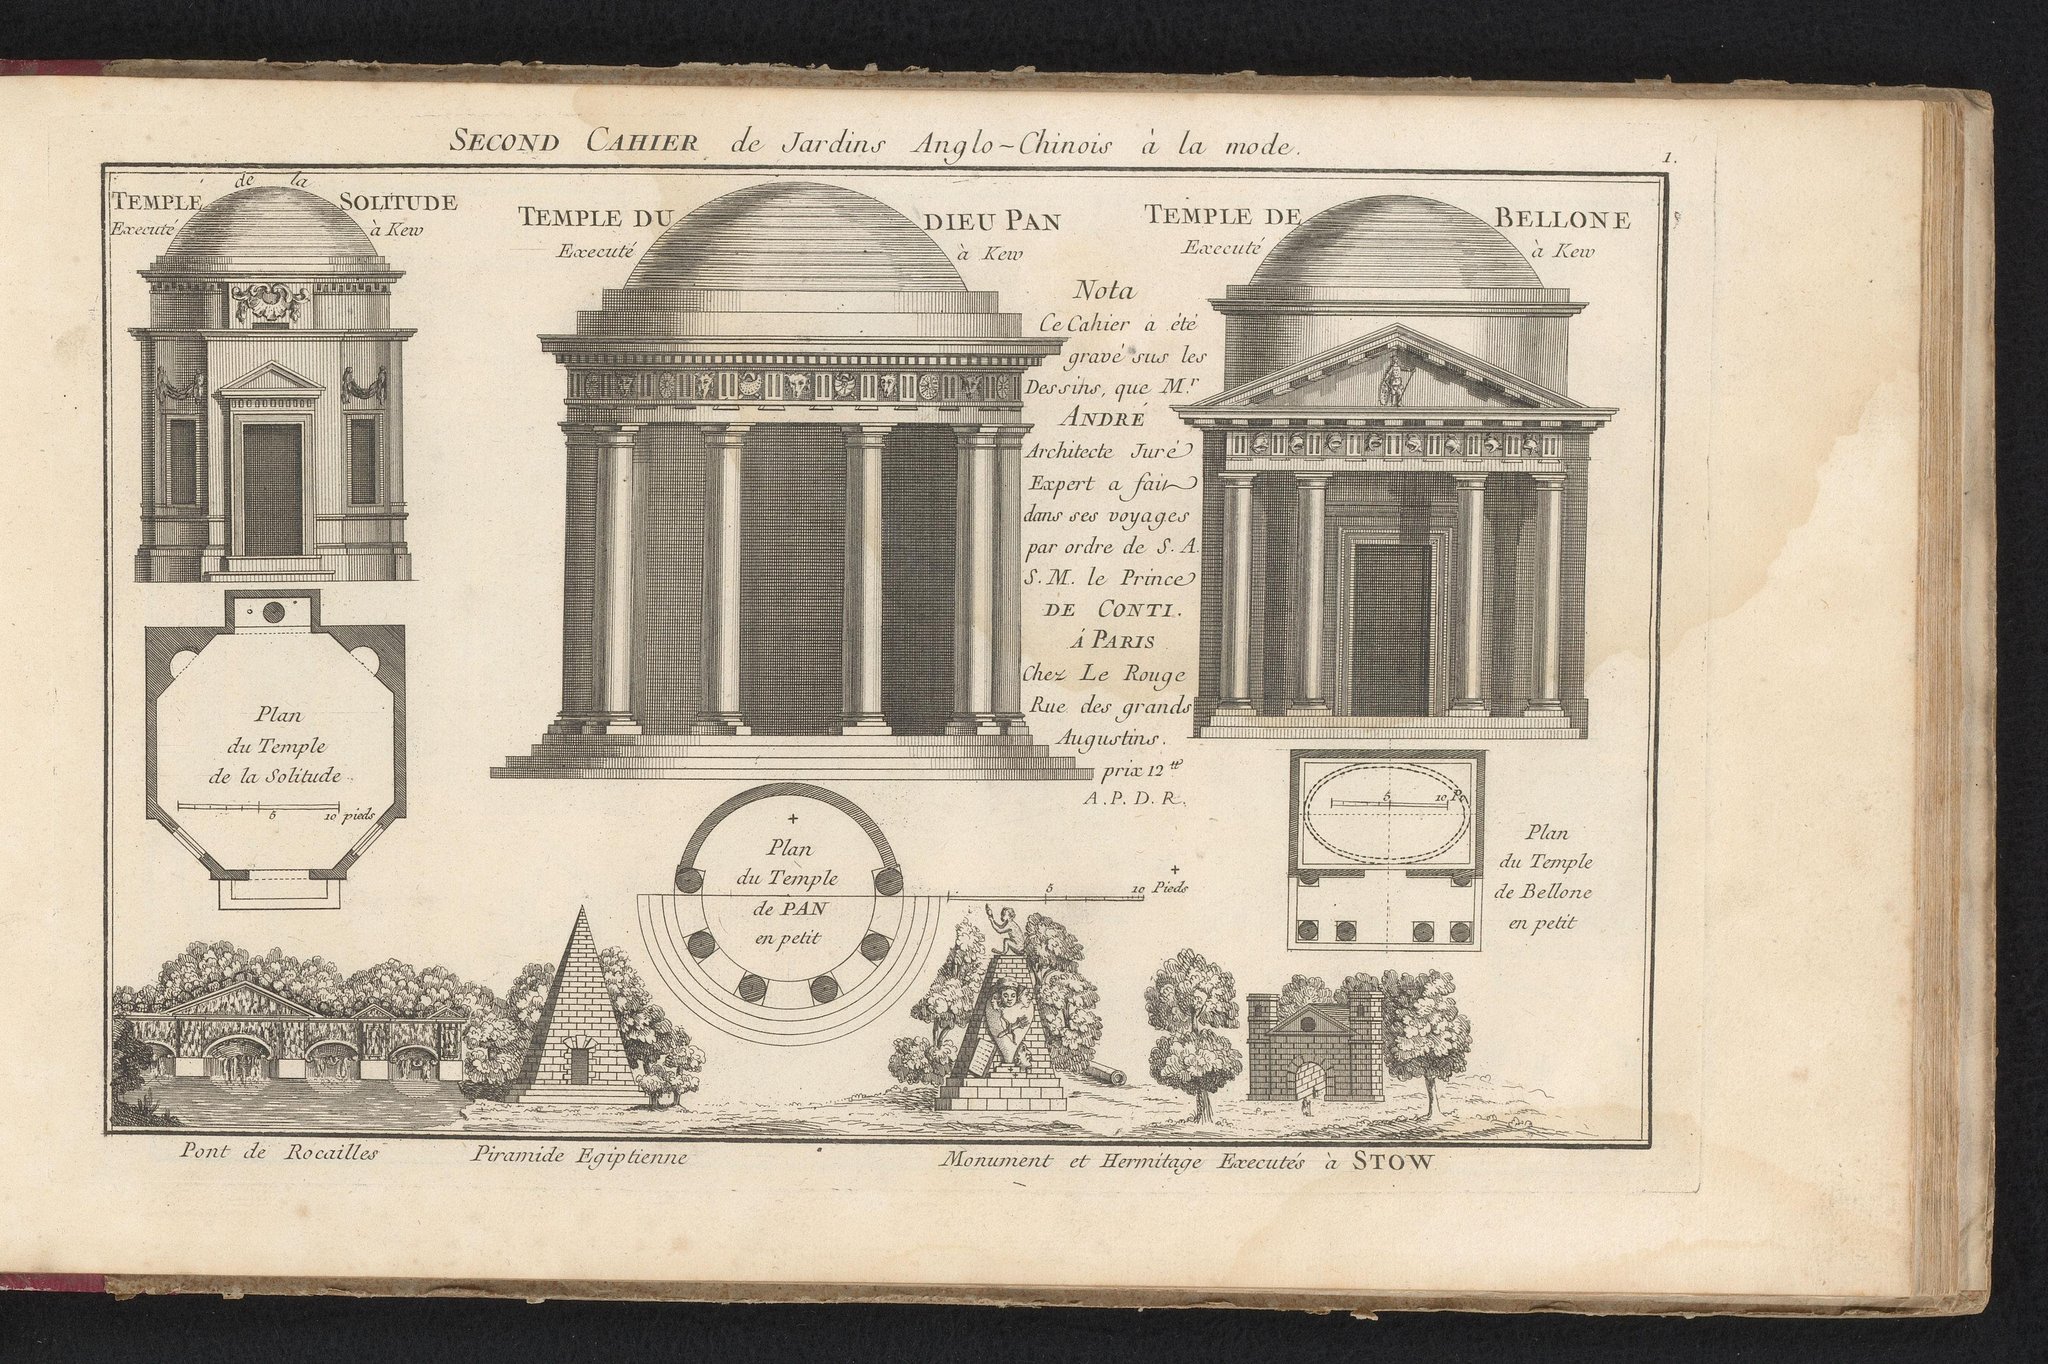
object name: titelprent, frontispice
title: Landschapstuinen in Chinees-Engelse stijl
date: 1775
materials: paper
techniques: engraving, etching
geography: paris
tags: pyramids (garden ornaments), garden buildings, hermitage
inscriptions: collector's mark: Lugt 2760, collector's mark: Lugt 2228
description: De serie 'Jardins anglo-chinois à la mode' verscheen in totaal in 21 zogeheten 'cahiers' (afleveringen). De huidige prent komt uit het tweede 'cahier'. Het Rijksmuseum Amsterdam bezit drie banden met daarin in totaal zes 'cahiers' van deze reeks. In de documentatie wordt verwezen naar een in de bibliotheek van het Rijksmuseum Amsterdam aanwezige facsimile van het complete werk.